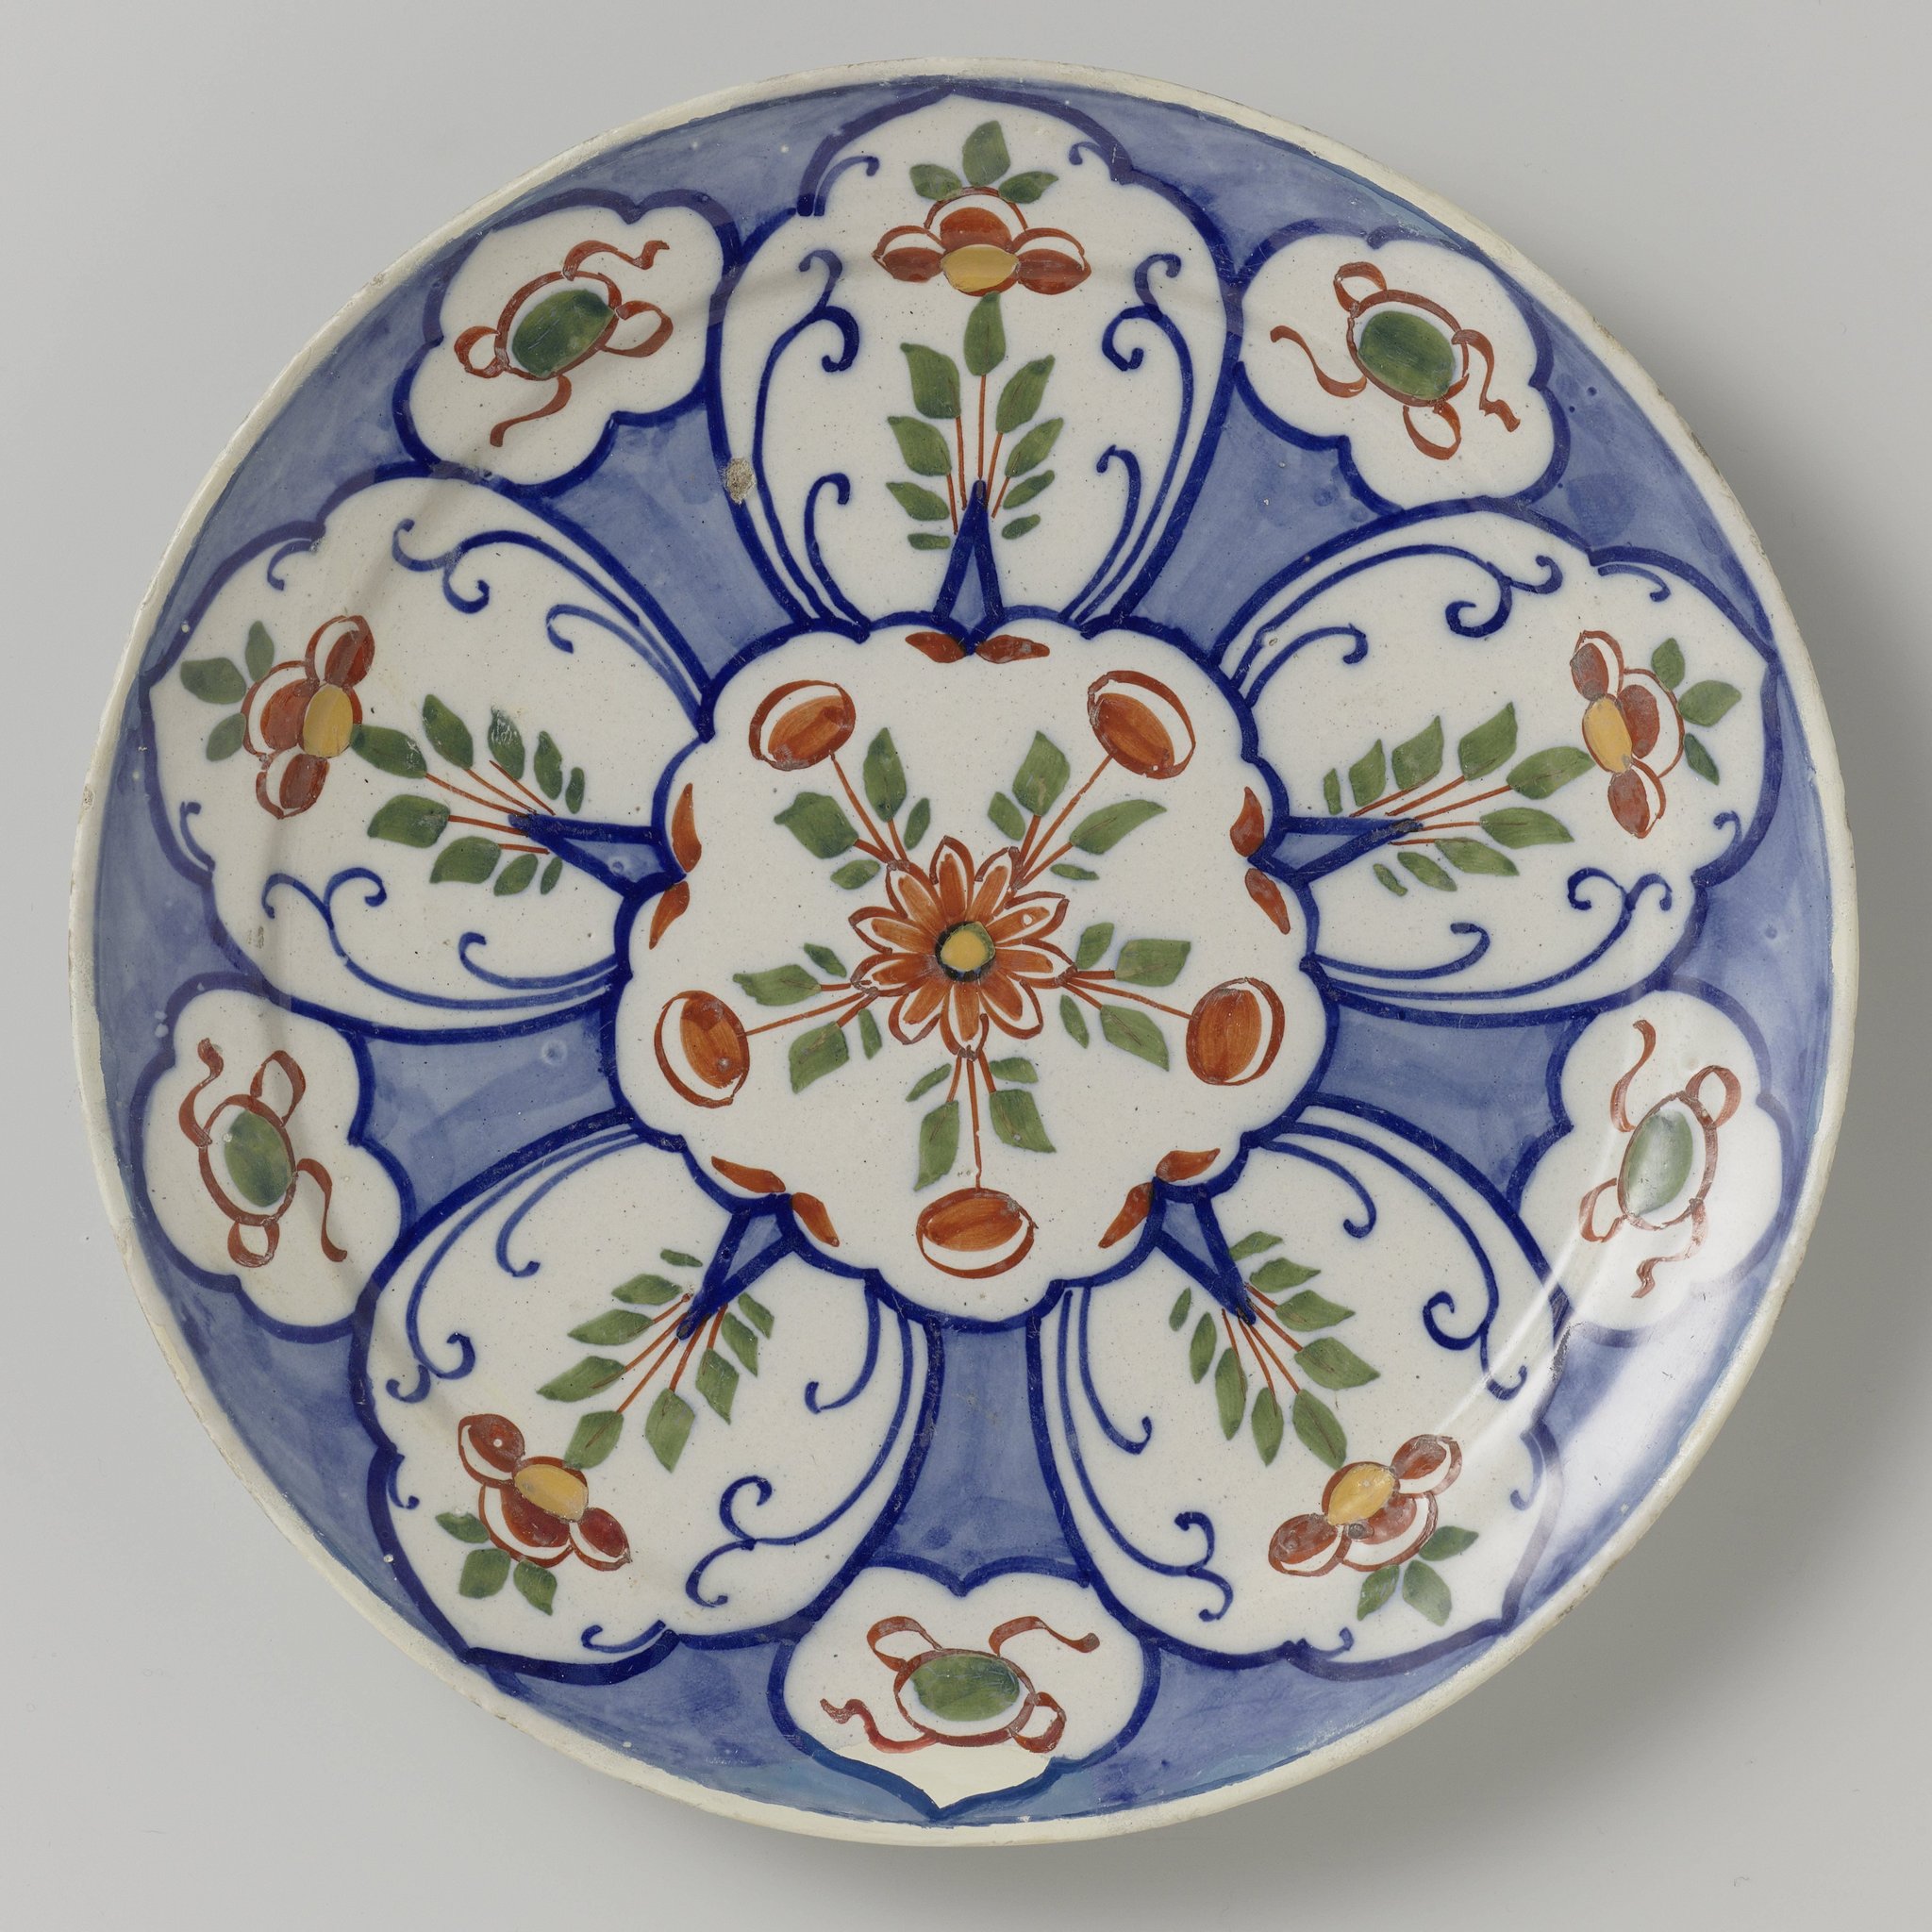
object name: plate dish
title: bord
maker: Anonymous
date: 1730-1770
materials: earthenware, glaze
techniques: painted, polychromy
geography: delft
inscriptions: mark: ‘19’, collector's mark: ‘koninklijk oudheidkundig genootschap no. 46’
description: Rond bord van veelkleurig beschilderde faience, met in het midden een medaillon met daarin een bloem en bladeren in de kleuren groen en rood. Daar omheen zijn op een blauwe achtergrond vijf witte vakken waarbinnen bloem- en bladversieringen. Bij het bord horen twee identieke borden met de invnrs. BK-KOG-2432-a en BK-KOG-2432-b.